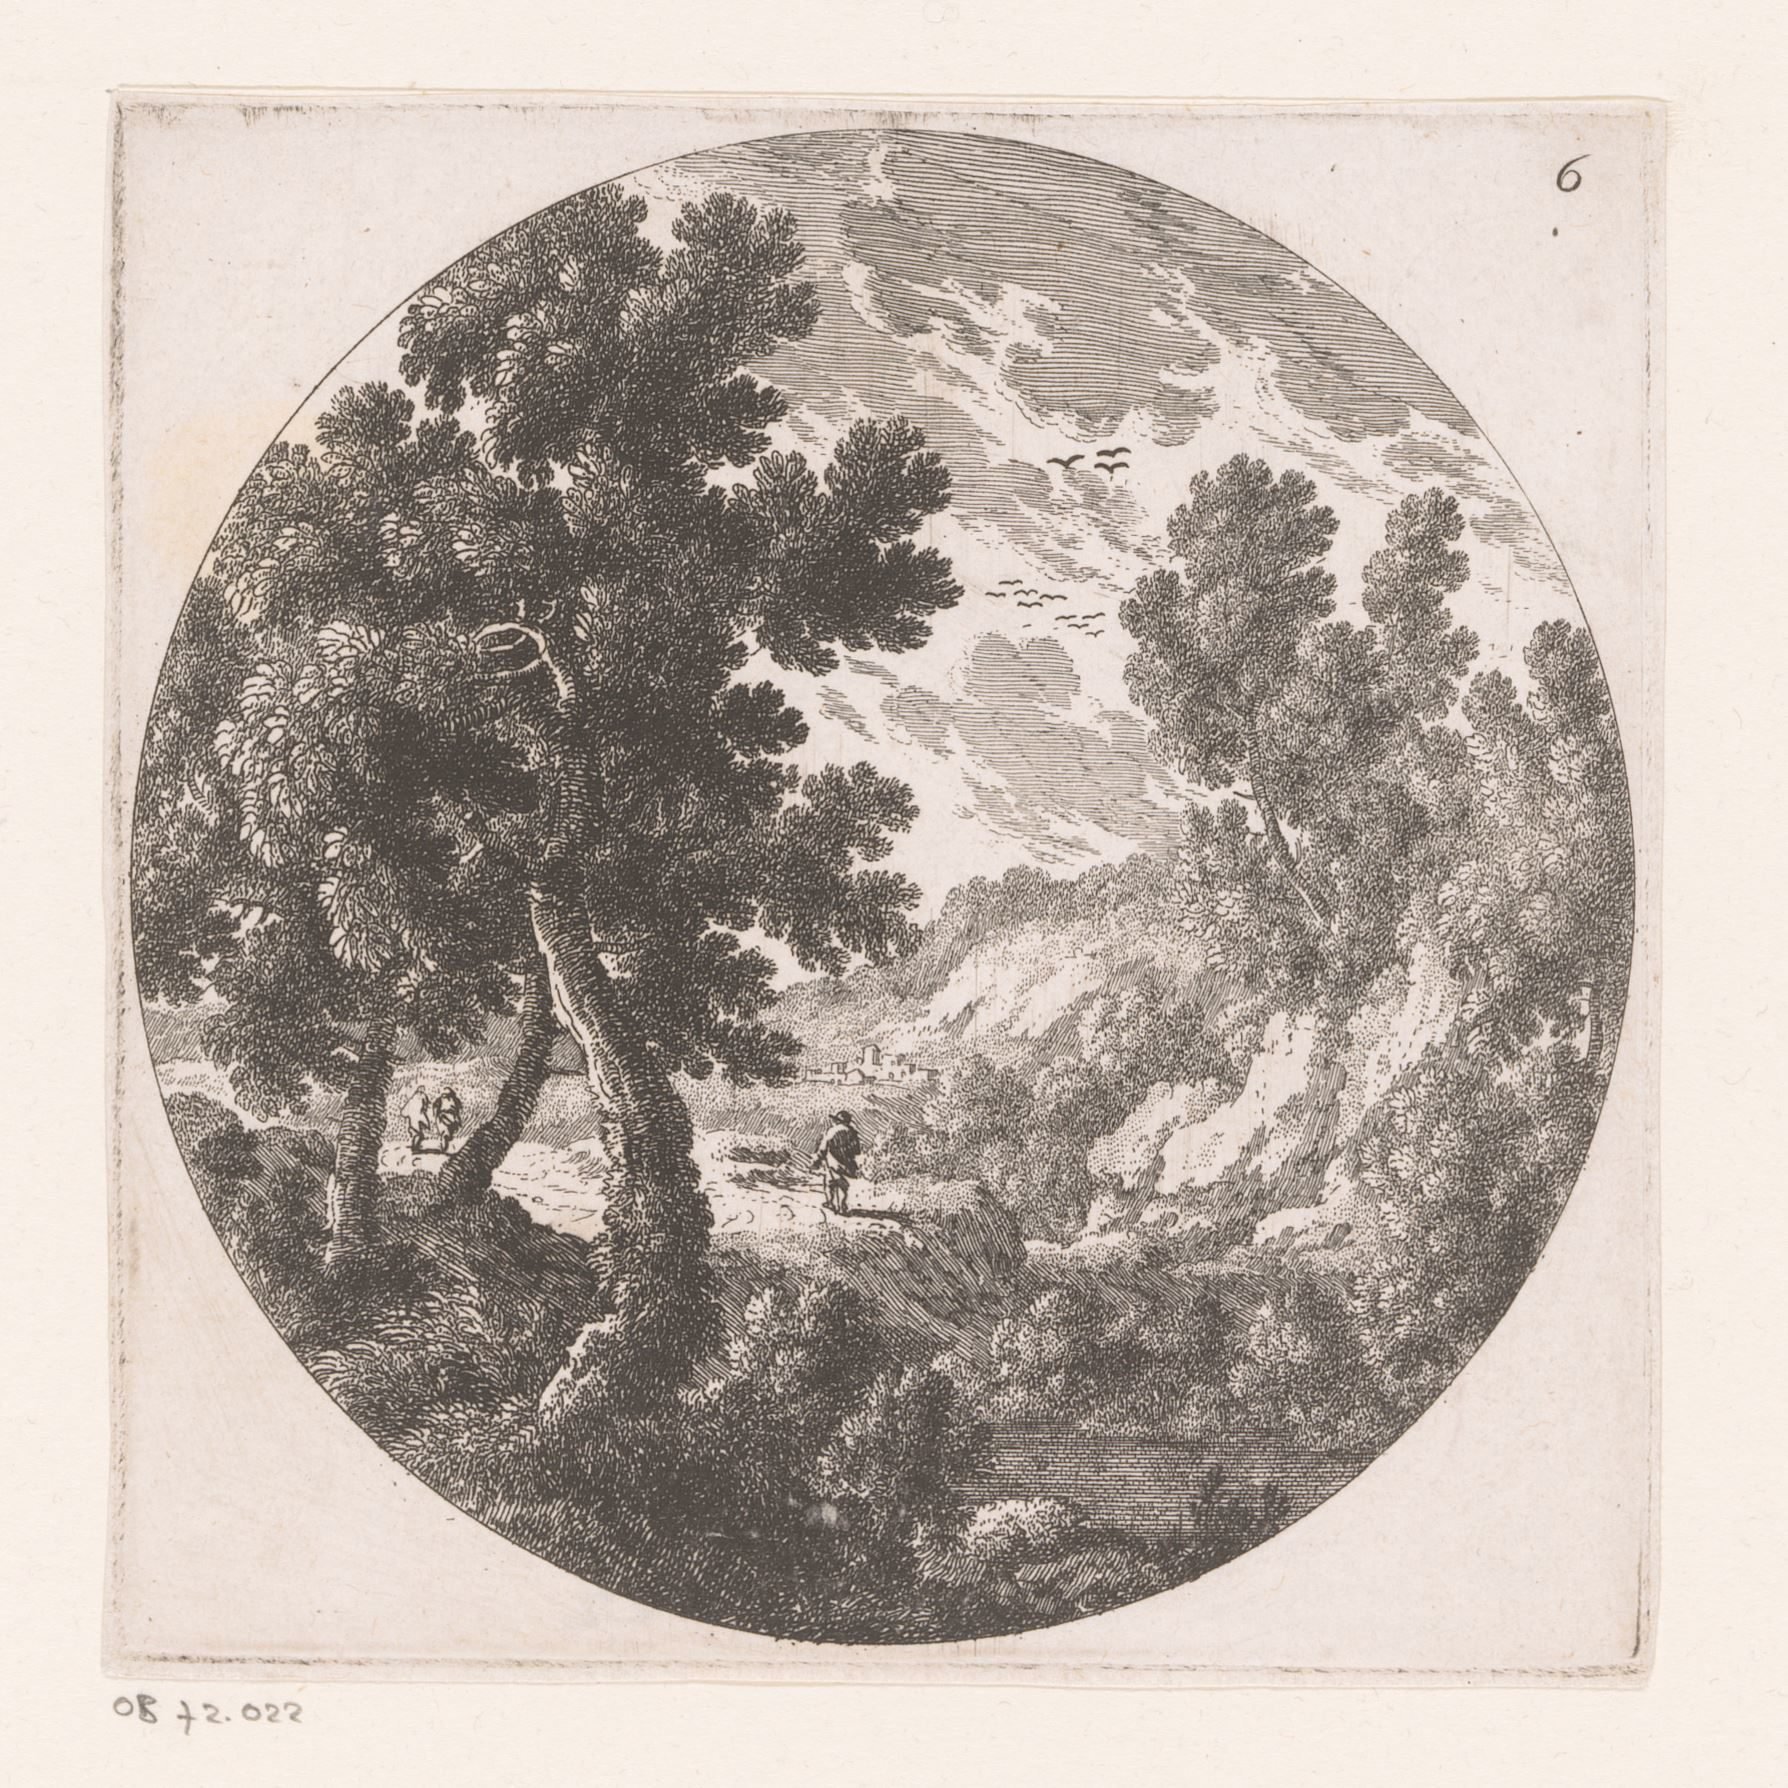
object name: print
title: Heuvelachtig landschap met bomen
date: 1613-1695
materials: paper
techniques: etching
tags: trees, mountains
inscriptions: collector's mark: Lugt 240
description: Prenten met het signatuur 'Perelle' kunnen zowel door vader Gabriel als door zonen Nicolas en Adam gemaakt zijn.